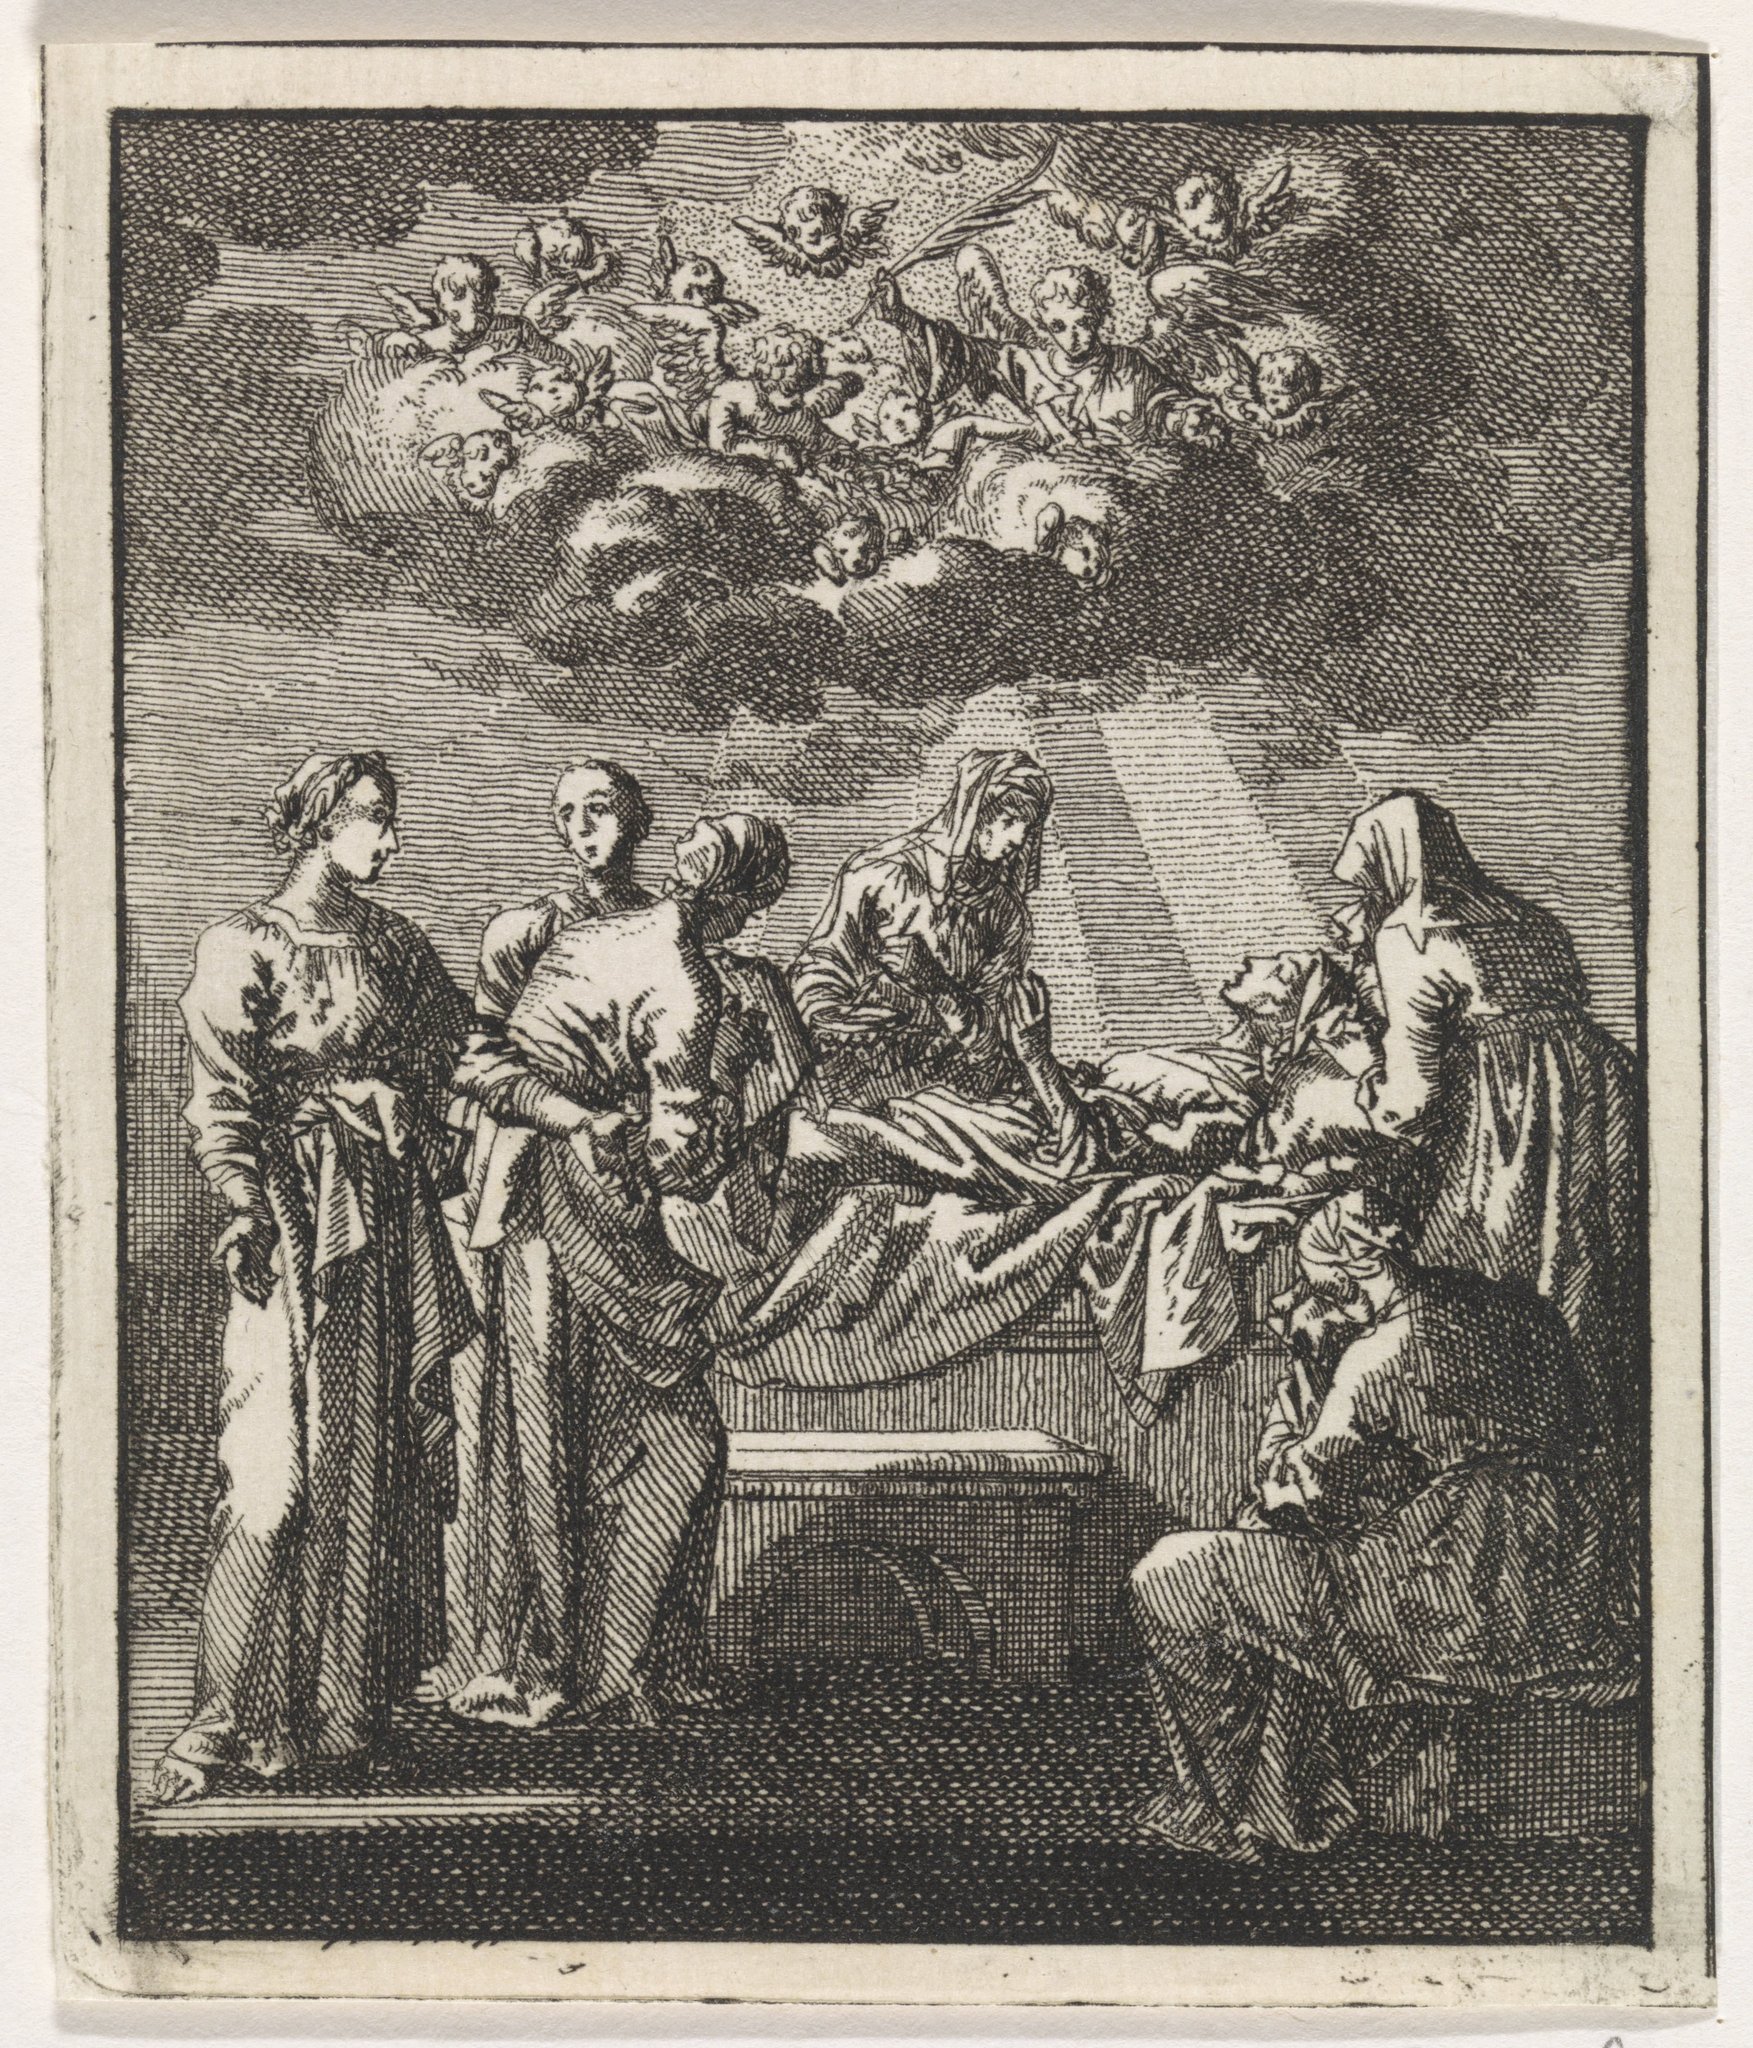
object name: print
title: Vrouw op haar sterfbed omringd door rouwende figuren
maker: jan luyken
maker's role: draughtsman, print maker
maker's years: 1649-1712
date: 1704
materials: paper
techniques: etching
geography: amsterdam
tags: deathbed, mourning the dead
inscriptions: collector's mark: Lugt 2228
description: Proefdruk van illustratie uit: Luyken, Jan. De zedelyke en stichtelyke gezangen. Amsterdam: Wed. Pieter Arentsz (II) en Cornelis van der Sys, 1704, p. 61.